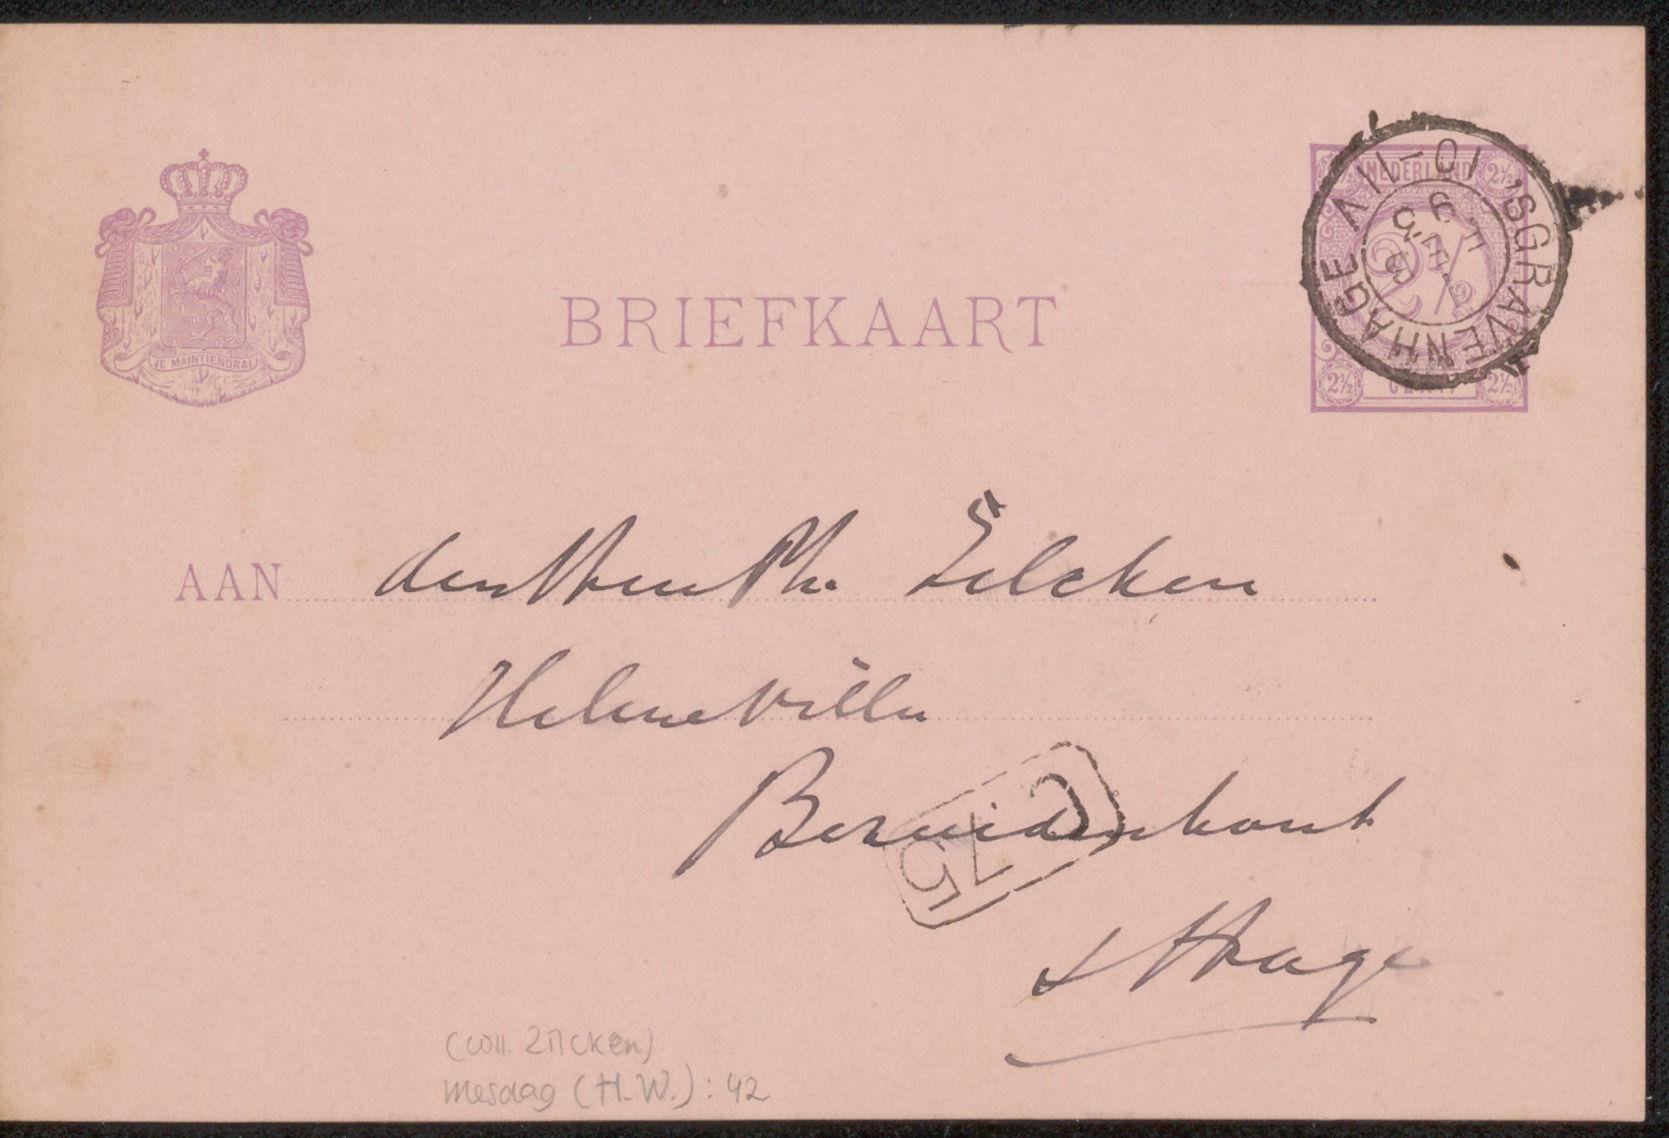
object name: postcard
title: Briefkaart aan Philip Zilcken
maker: hendrik willem mesdag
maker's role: draughtsman, painter, print maker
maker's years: 1831-1915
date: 1893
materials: cardboard, ink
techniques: pen, writing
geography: the hague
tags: amsterdam, auctioneer, abraham preyer, the hague, painter, philip zilcken